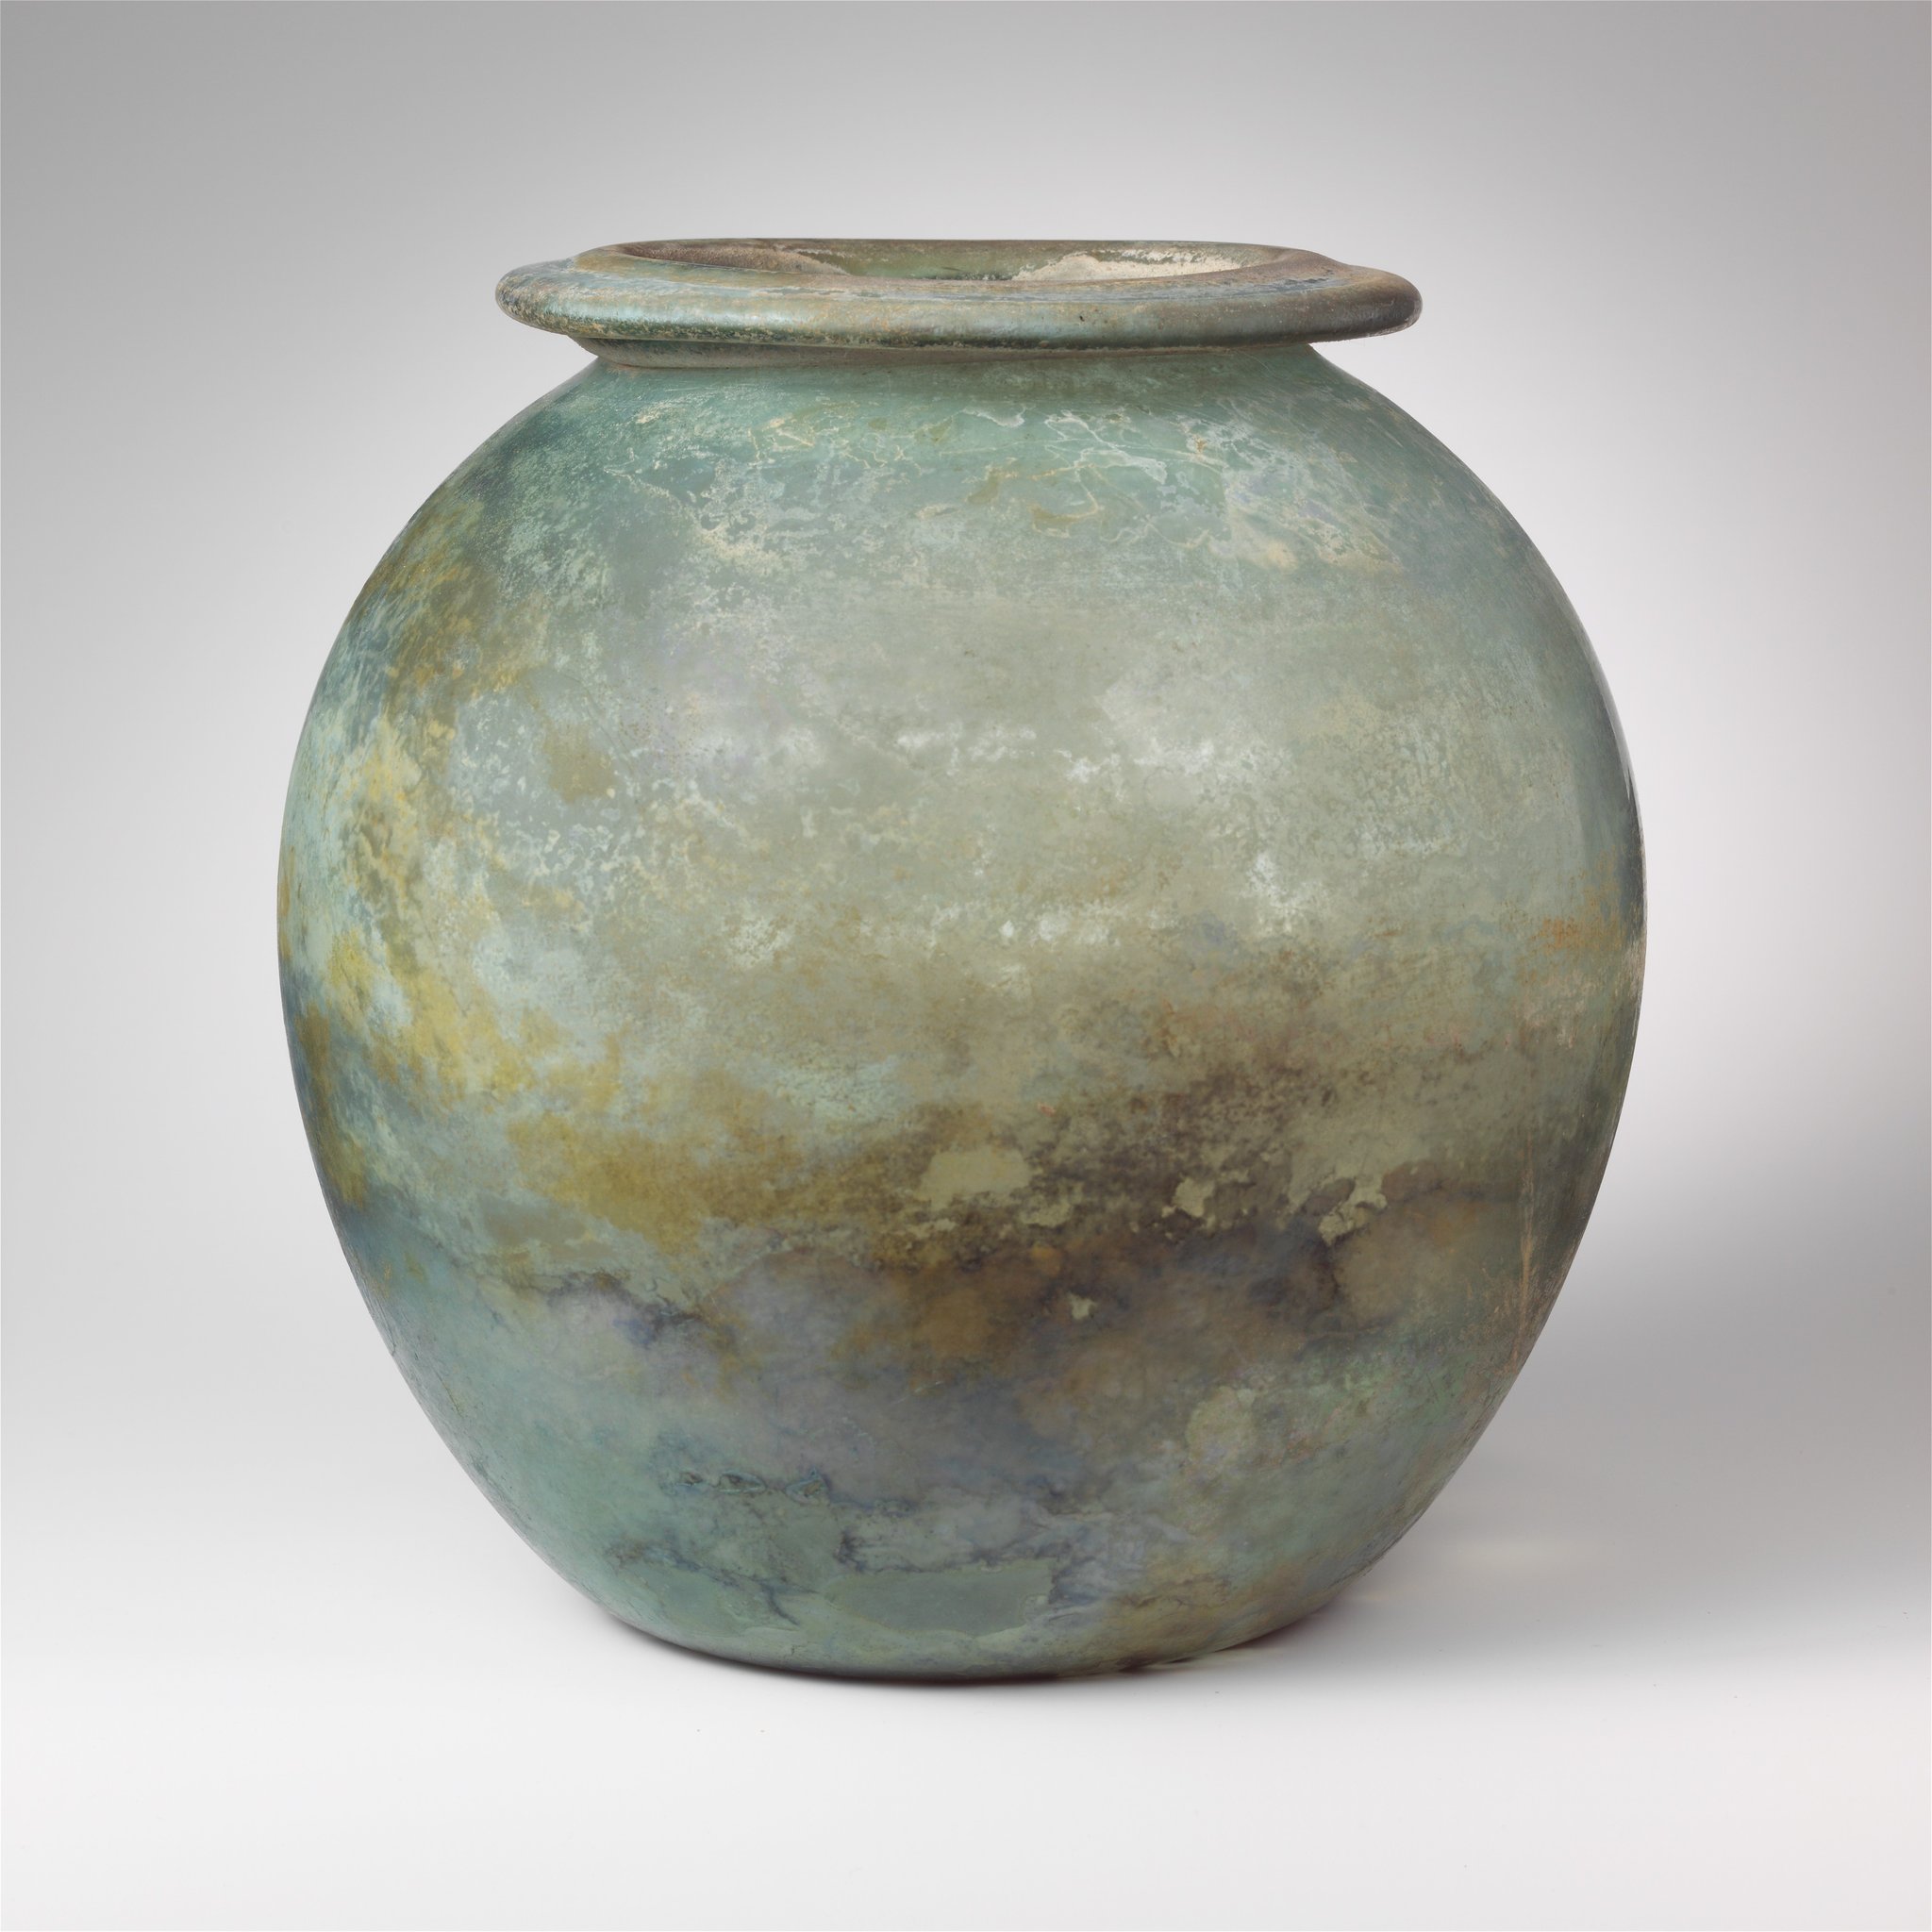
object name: jar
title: Glass cinerary urn (olla)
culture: roman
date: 34-200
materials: glass